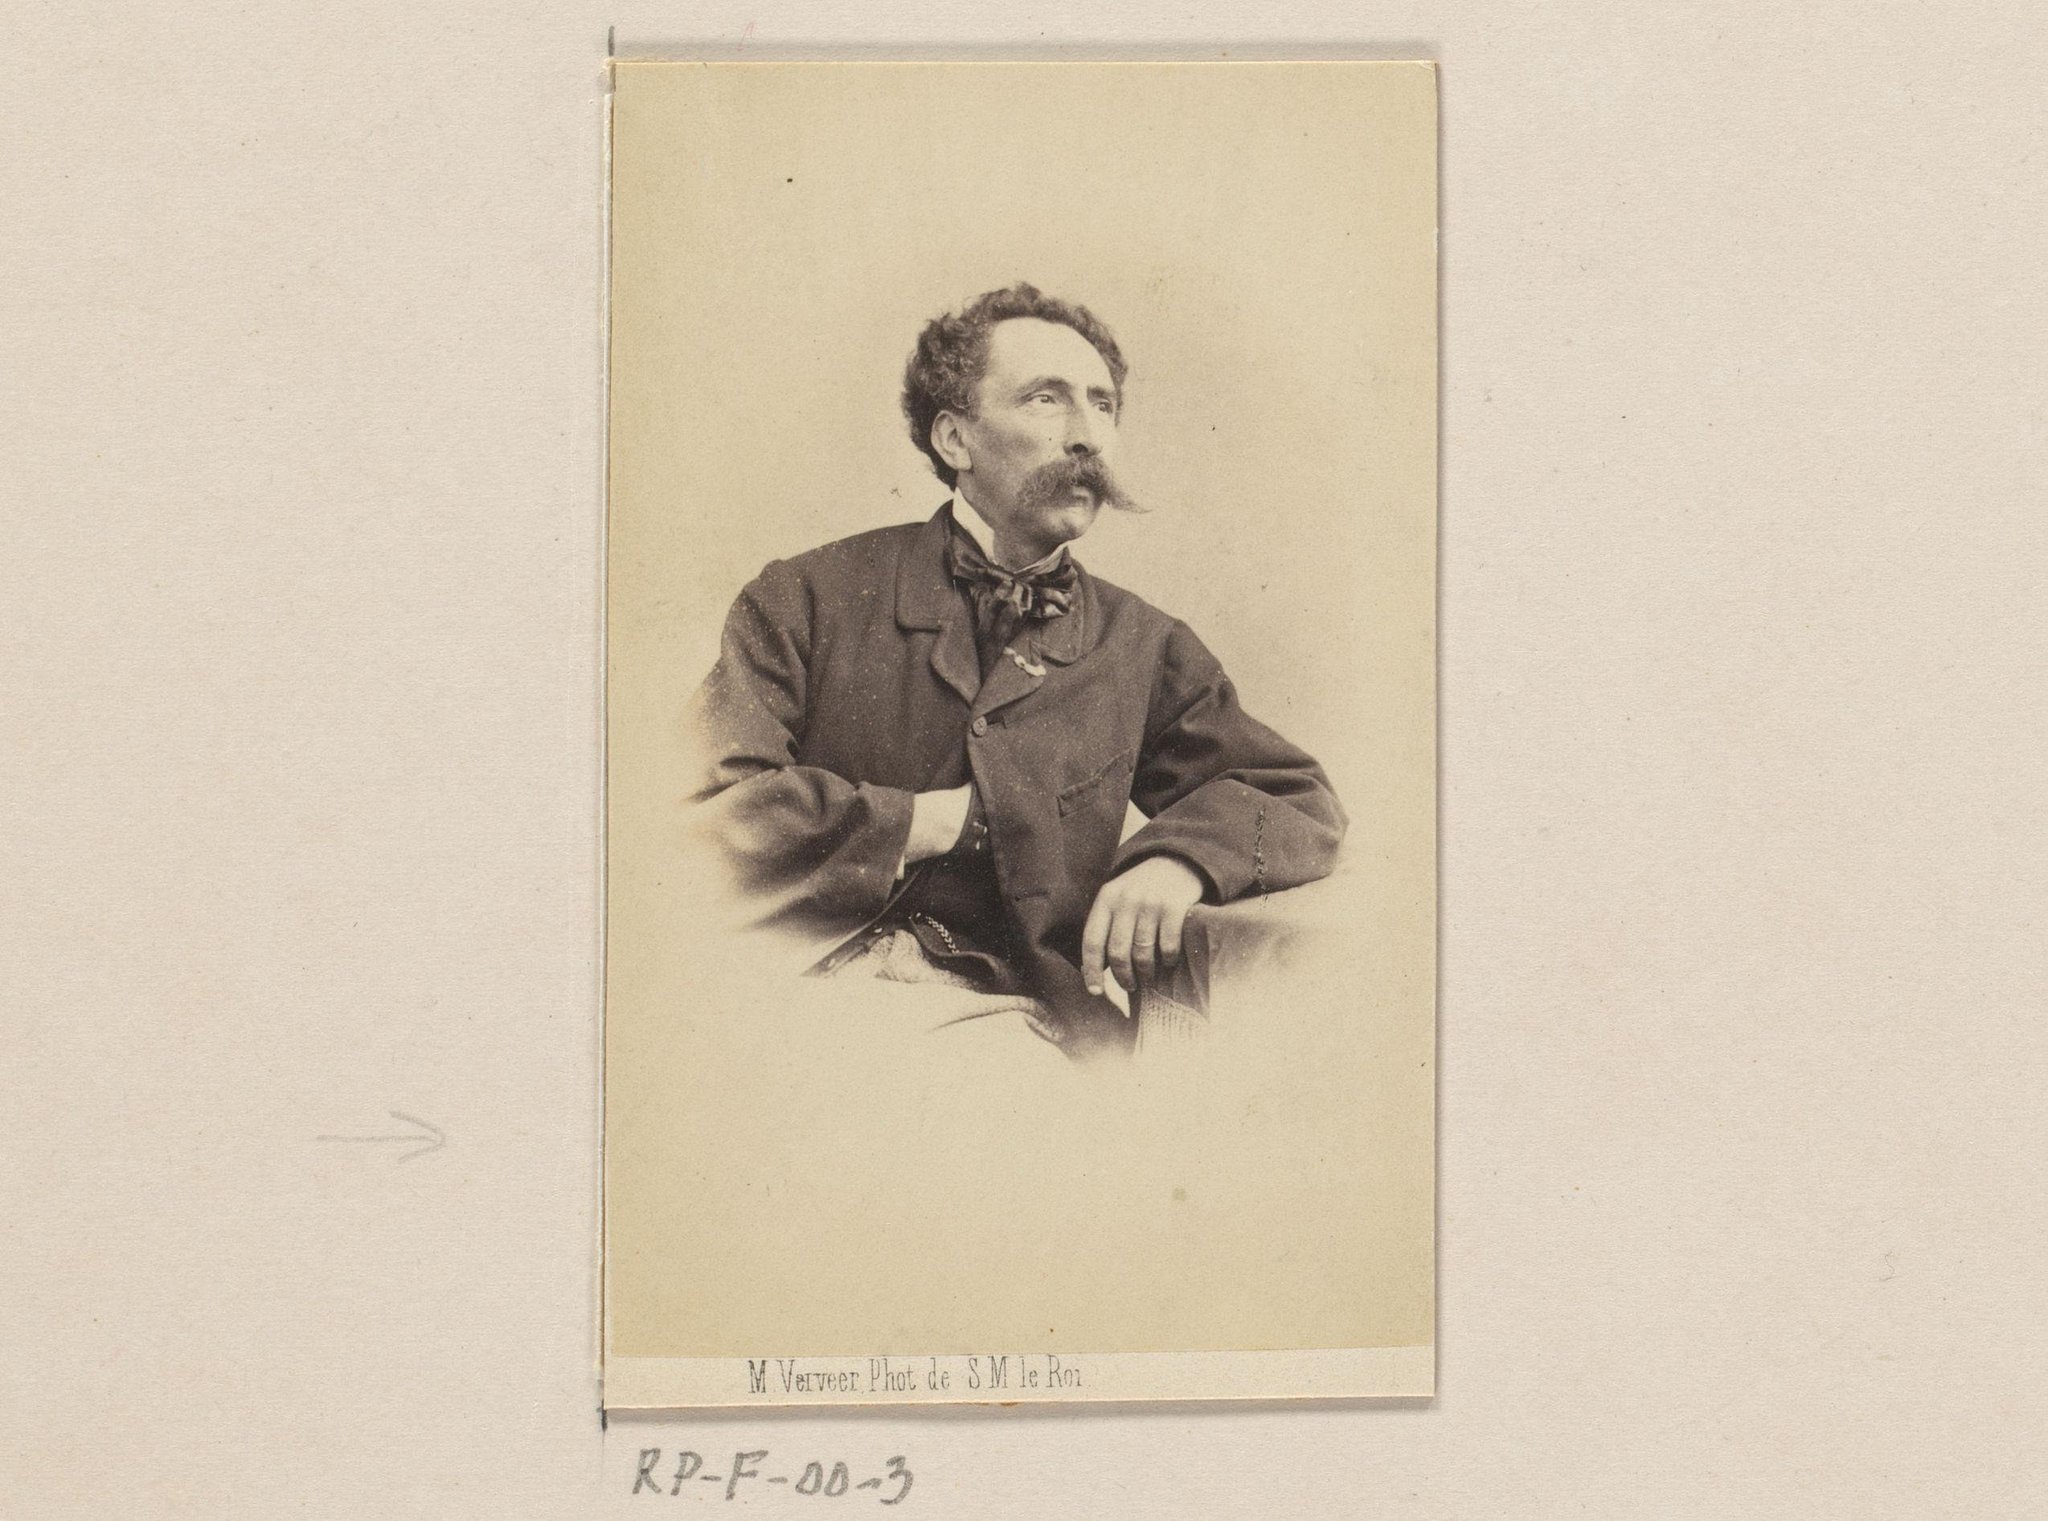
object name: photograph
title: Portret van Salomon Leonardus Verveer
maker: maurits verveer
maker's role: painter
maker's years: 1817-1903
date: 1861-1876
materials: cardboard, paper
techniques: albumen print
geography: the hague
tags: the hague, salomon leonardus verveer, historical persons, portrait, self-portrait of painter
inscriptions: inscription: ‘Sam L. V/ Sam L. Verveer’